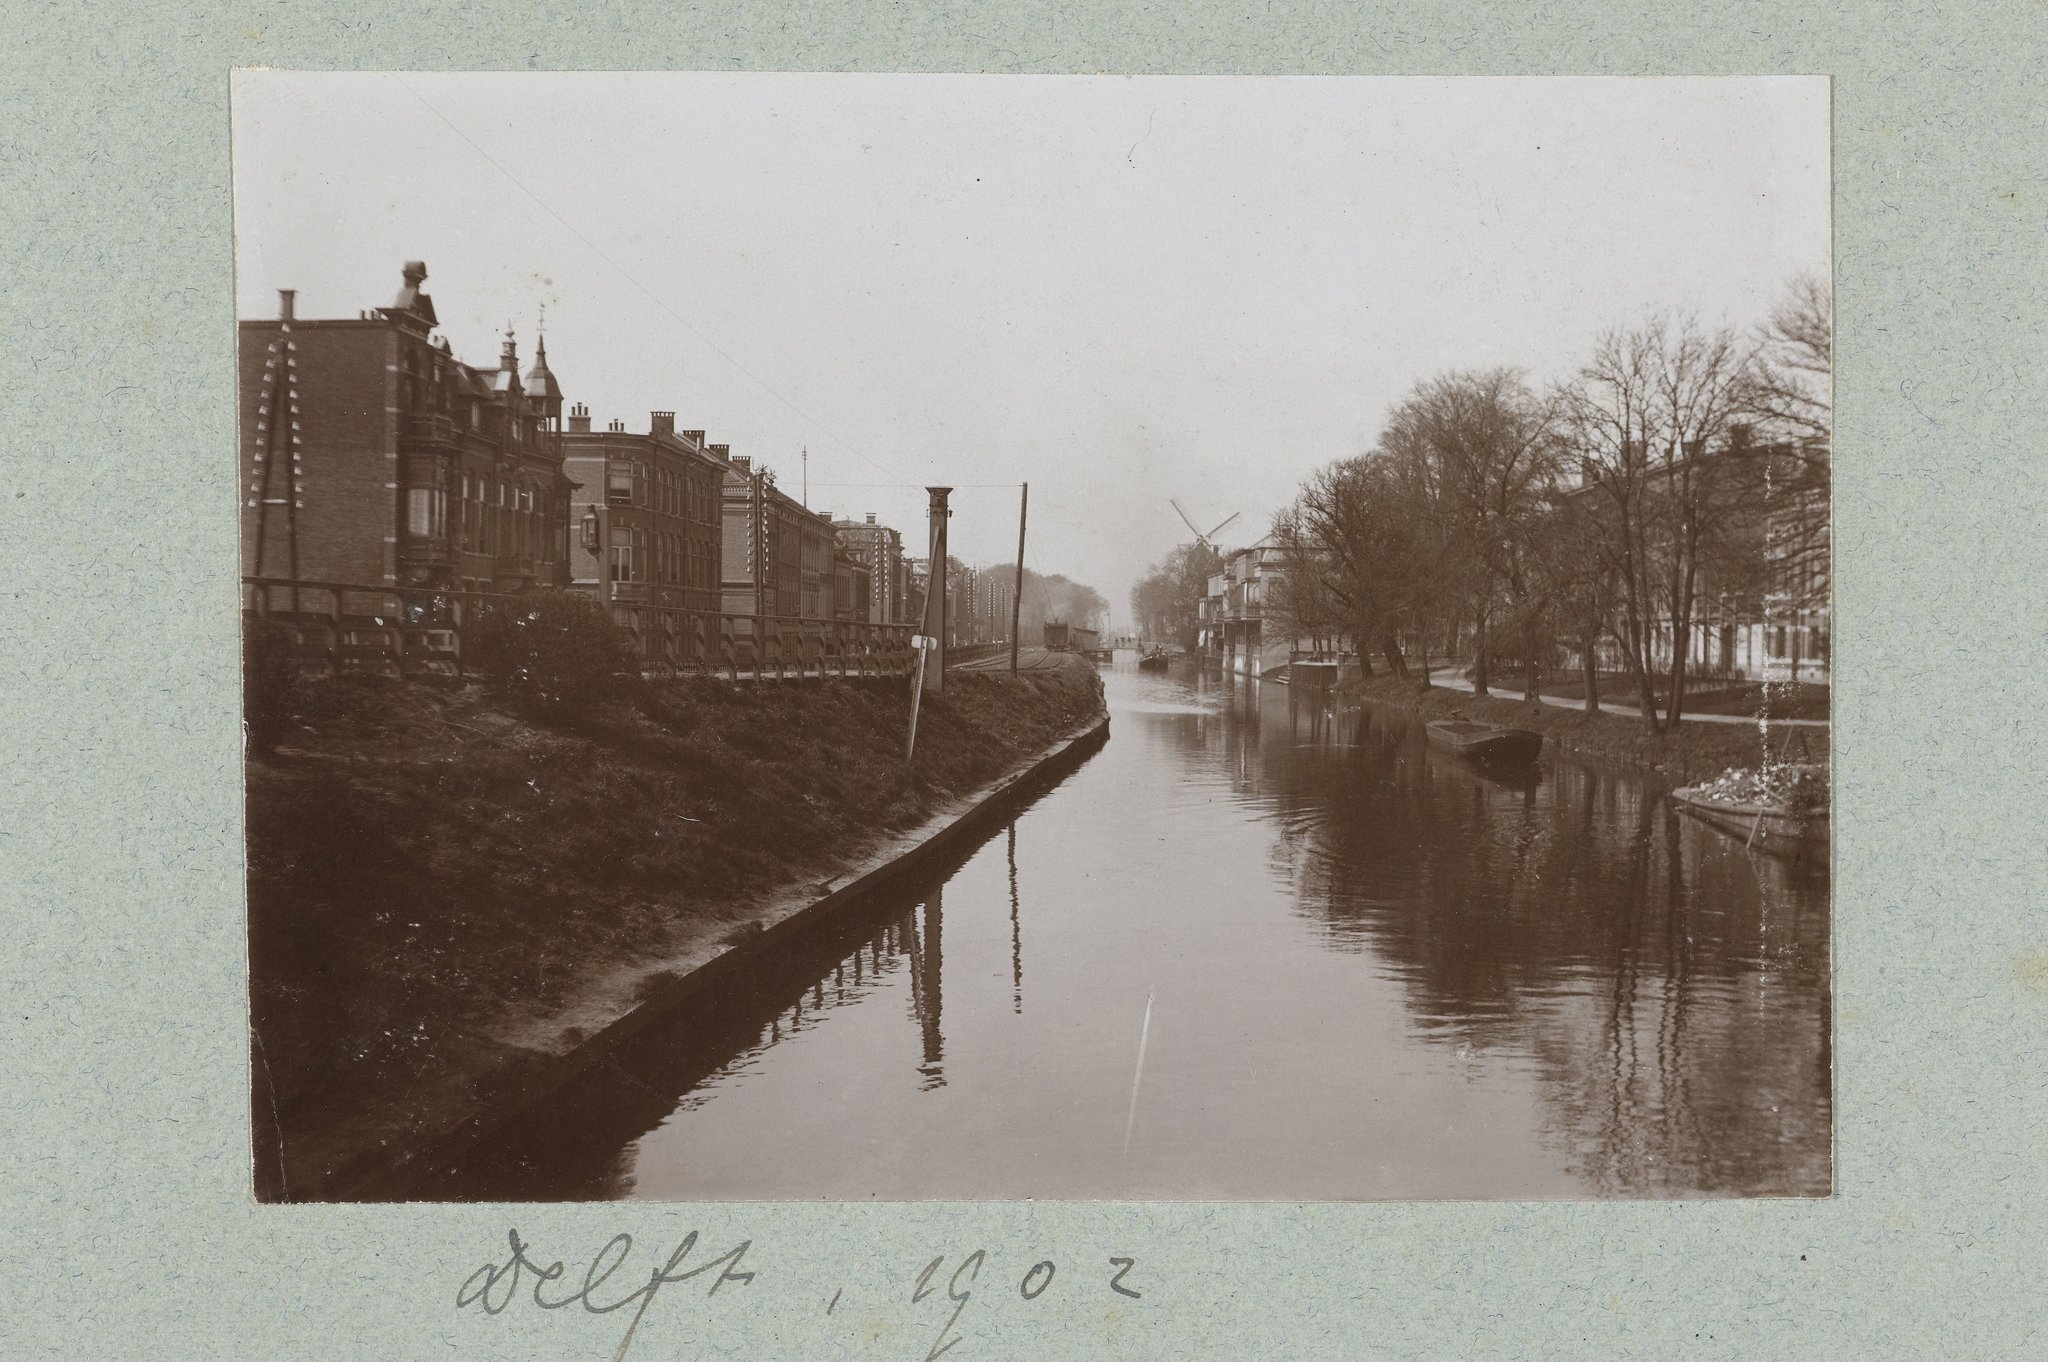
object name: photograph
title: Photographieën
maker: frits freerks fontein fz.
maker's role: fotograaf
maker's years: 1882-1928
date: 1902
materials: cardboard, paper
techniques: gelatin silver print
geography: netherlands